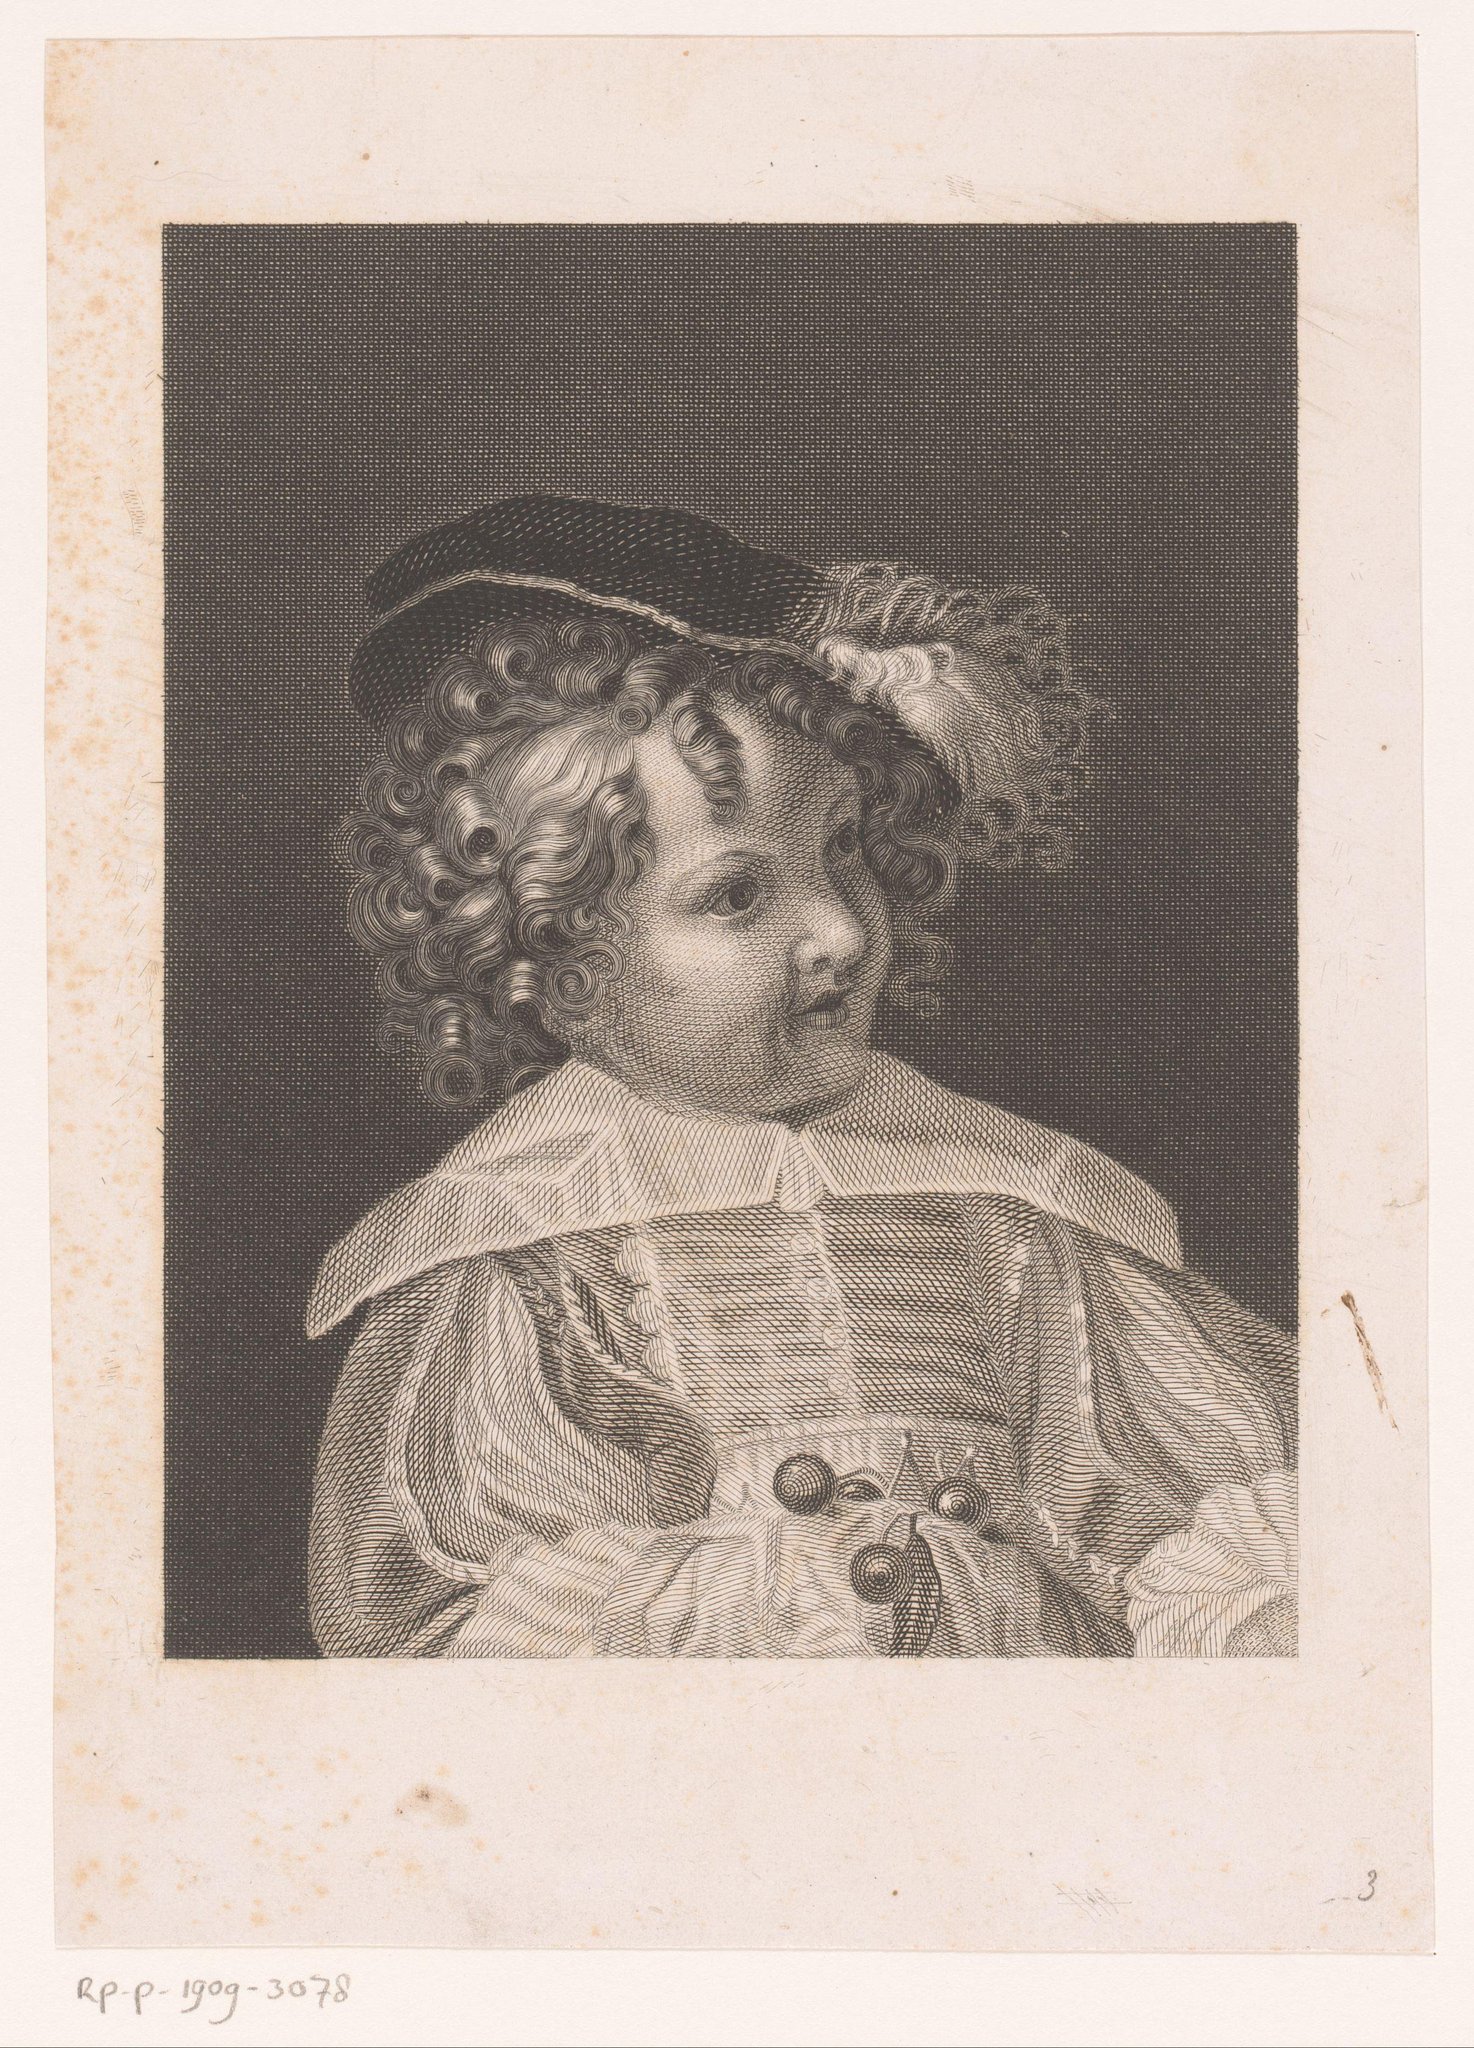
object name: print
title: Portret van een onbekend kind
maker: erin corr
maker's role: draughtsman, print maker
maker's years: 1805-1862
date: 1815-1862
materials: paper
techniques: engraving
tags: child, historical persons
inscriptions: collector's mark: Lugt 2228